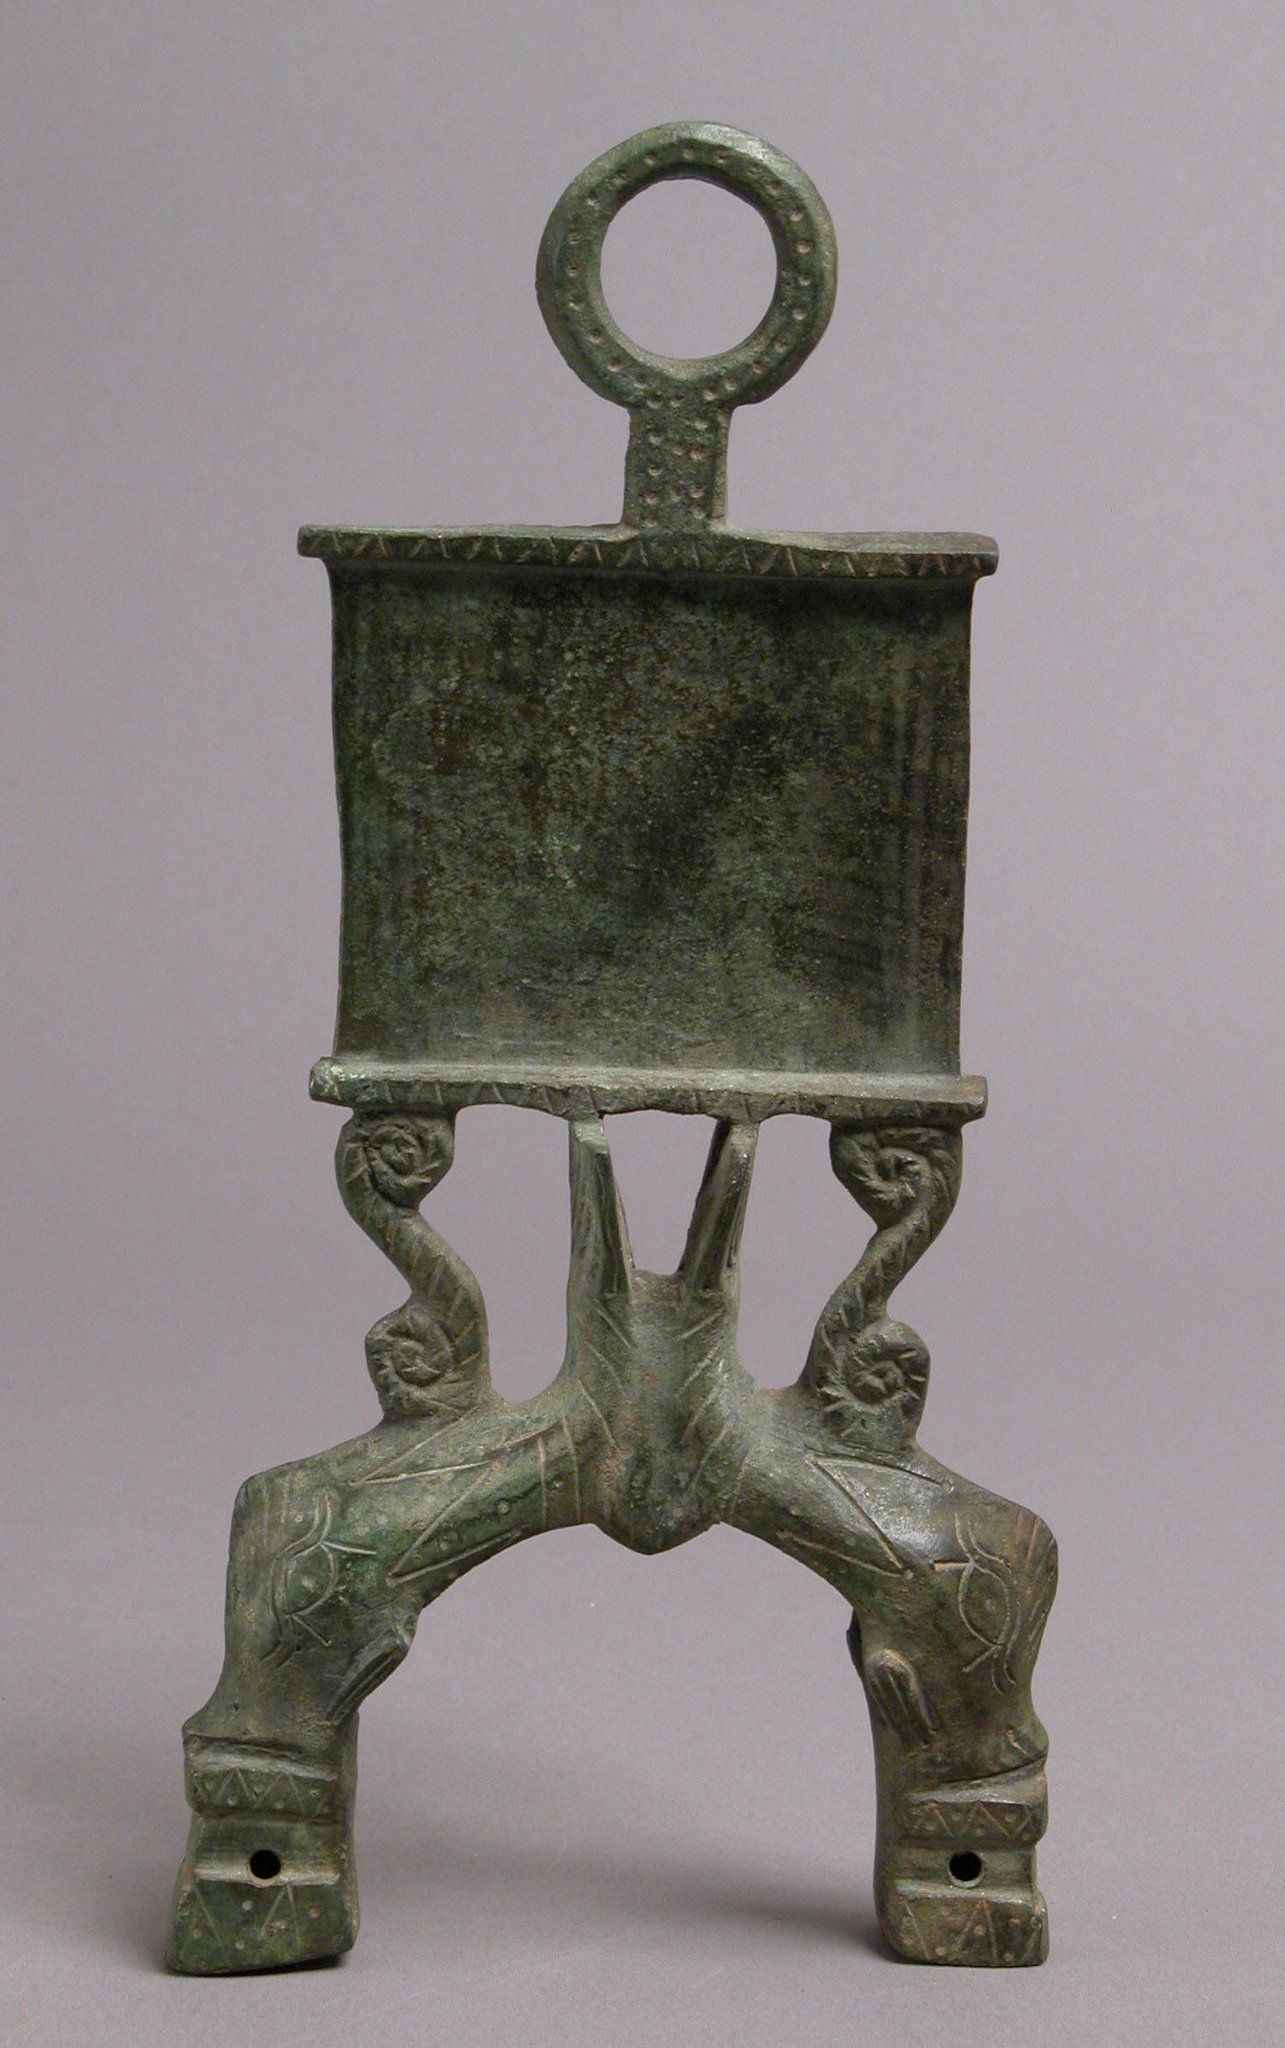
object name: lamp handle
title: Lamp Handle with Dolphins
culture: byzantine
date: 301-500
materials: copper alloy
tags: dolphins